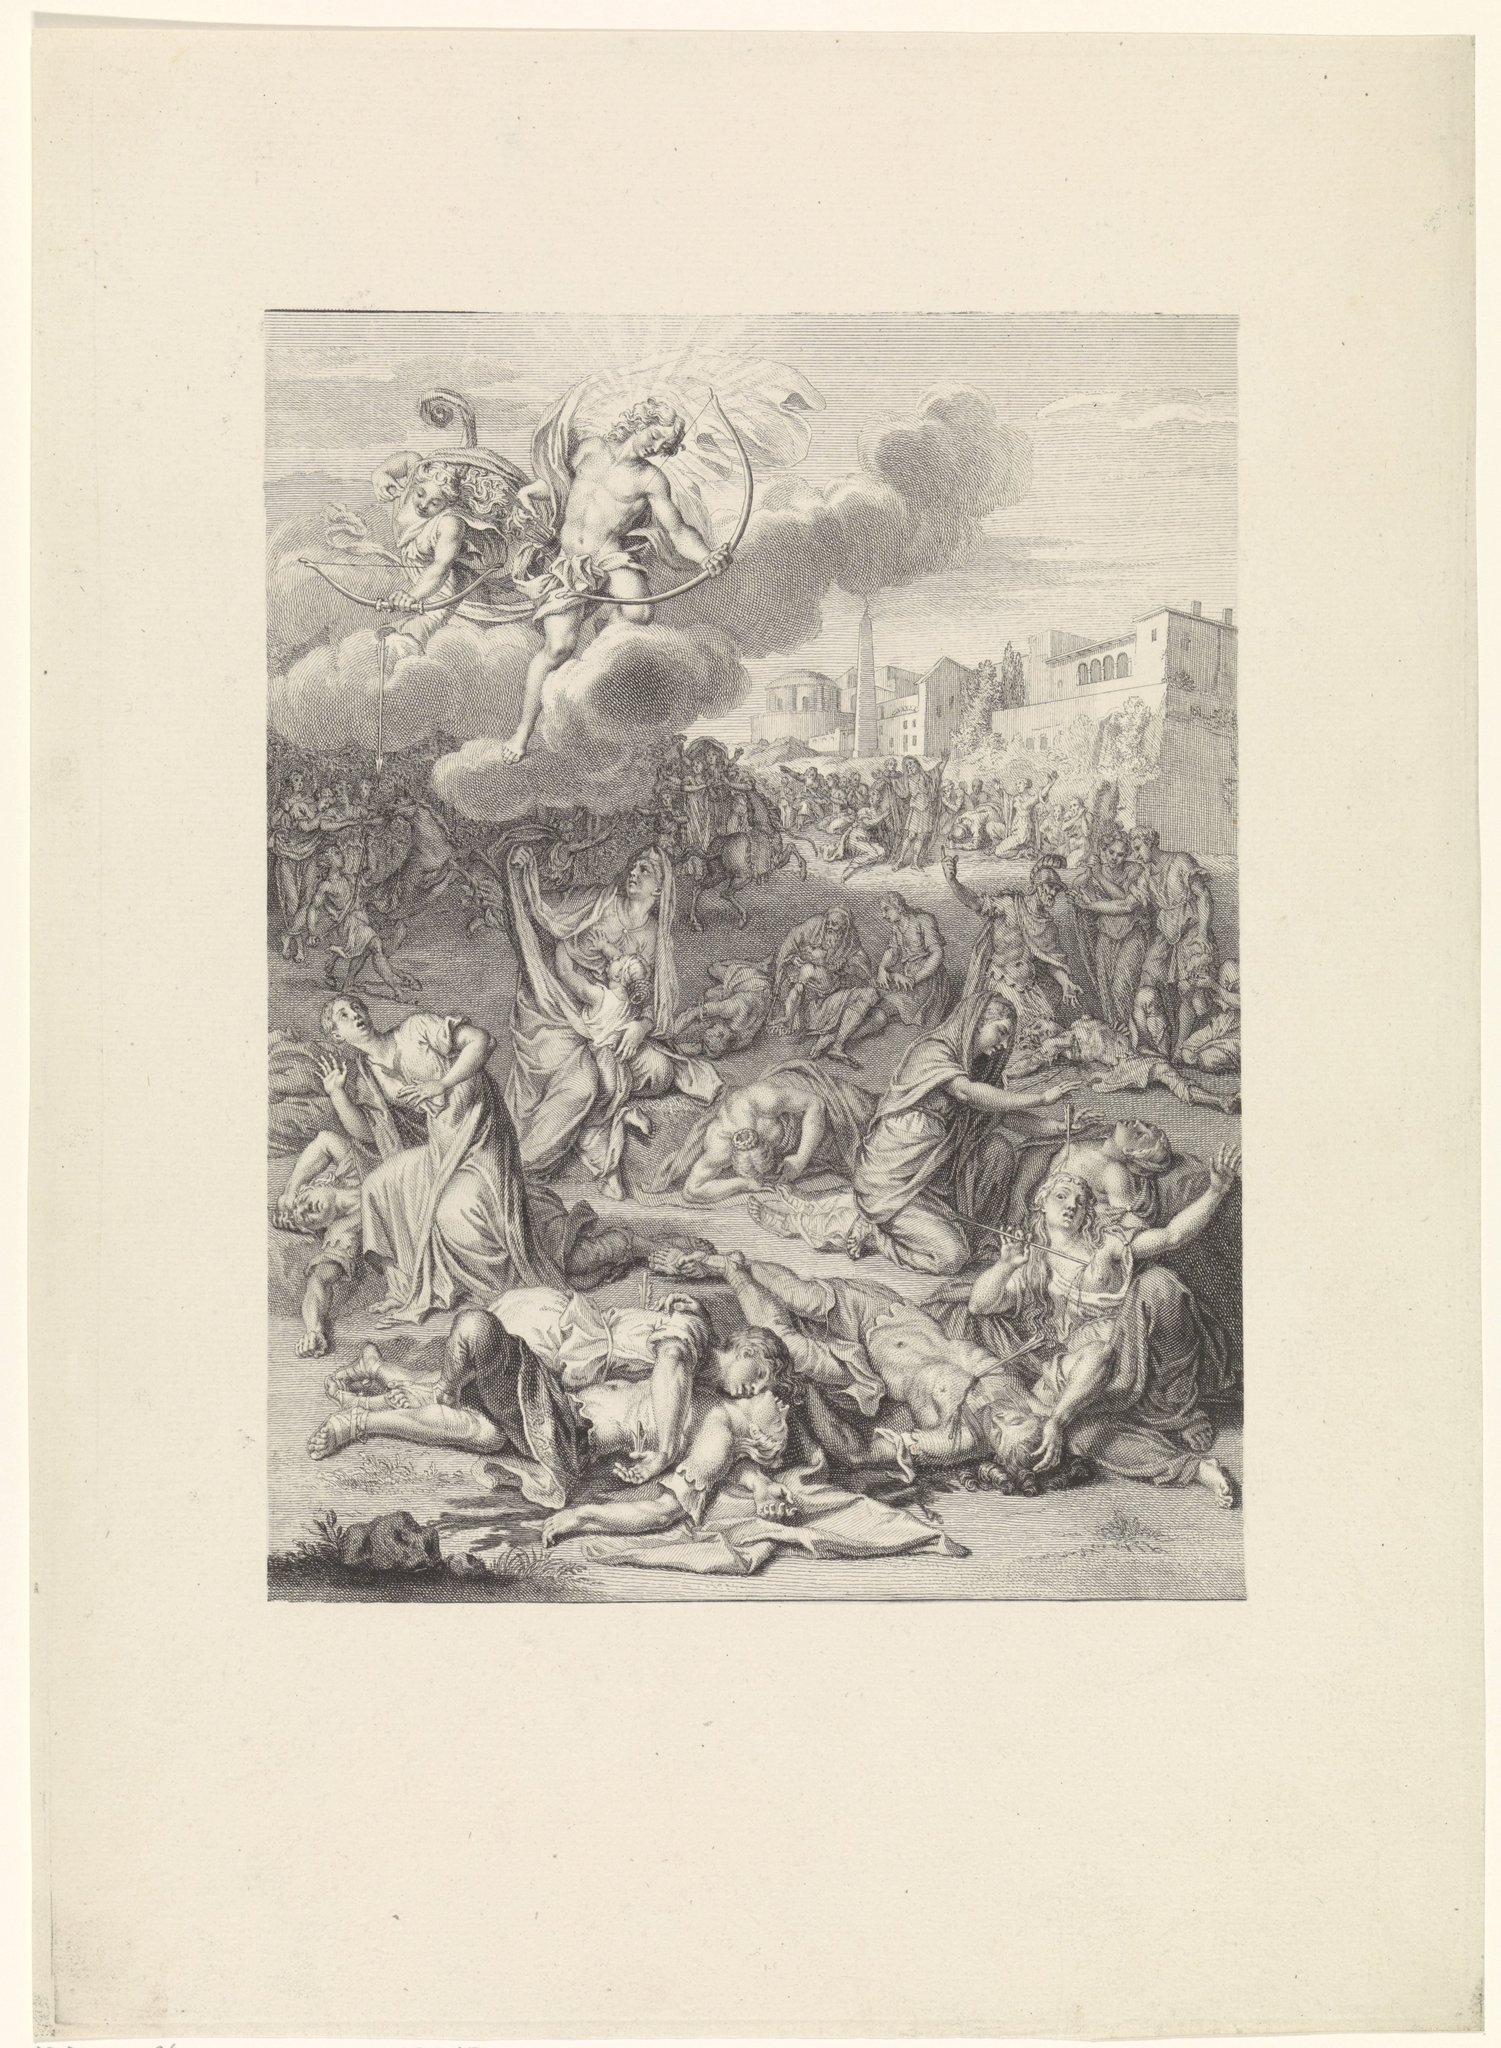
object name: print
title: Apollo en Diana doden de kinderen van Niobe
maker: bernard picart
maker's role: draughtsman, print maker, publisher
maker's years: 1673-1733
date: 1733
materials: paper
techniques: engraving, etching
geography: amsterdam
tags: apollo and diana kill niobe's children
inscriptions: collector's mark: Lugt 2233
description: Prent ook als illustratie gebruikt in: Beaumarchais, Antoine de La Barre de. Le Temple des Muses: orné de 60 tableaux où sont représentés les événemens les plus remarquables de l'antiquité fabuleuse. Amsterdam: Zacharias Chatelain (II), 1733.